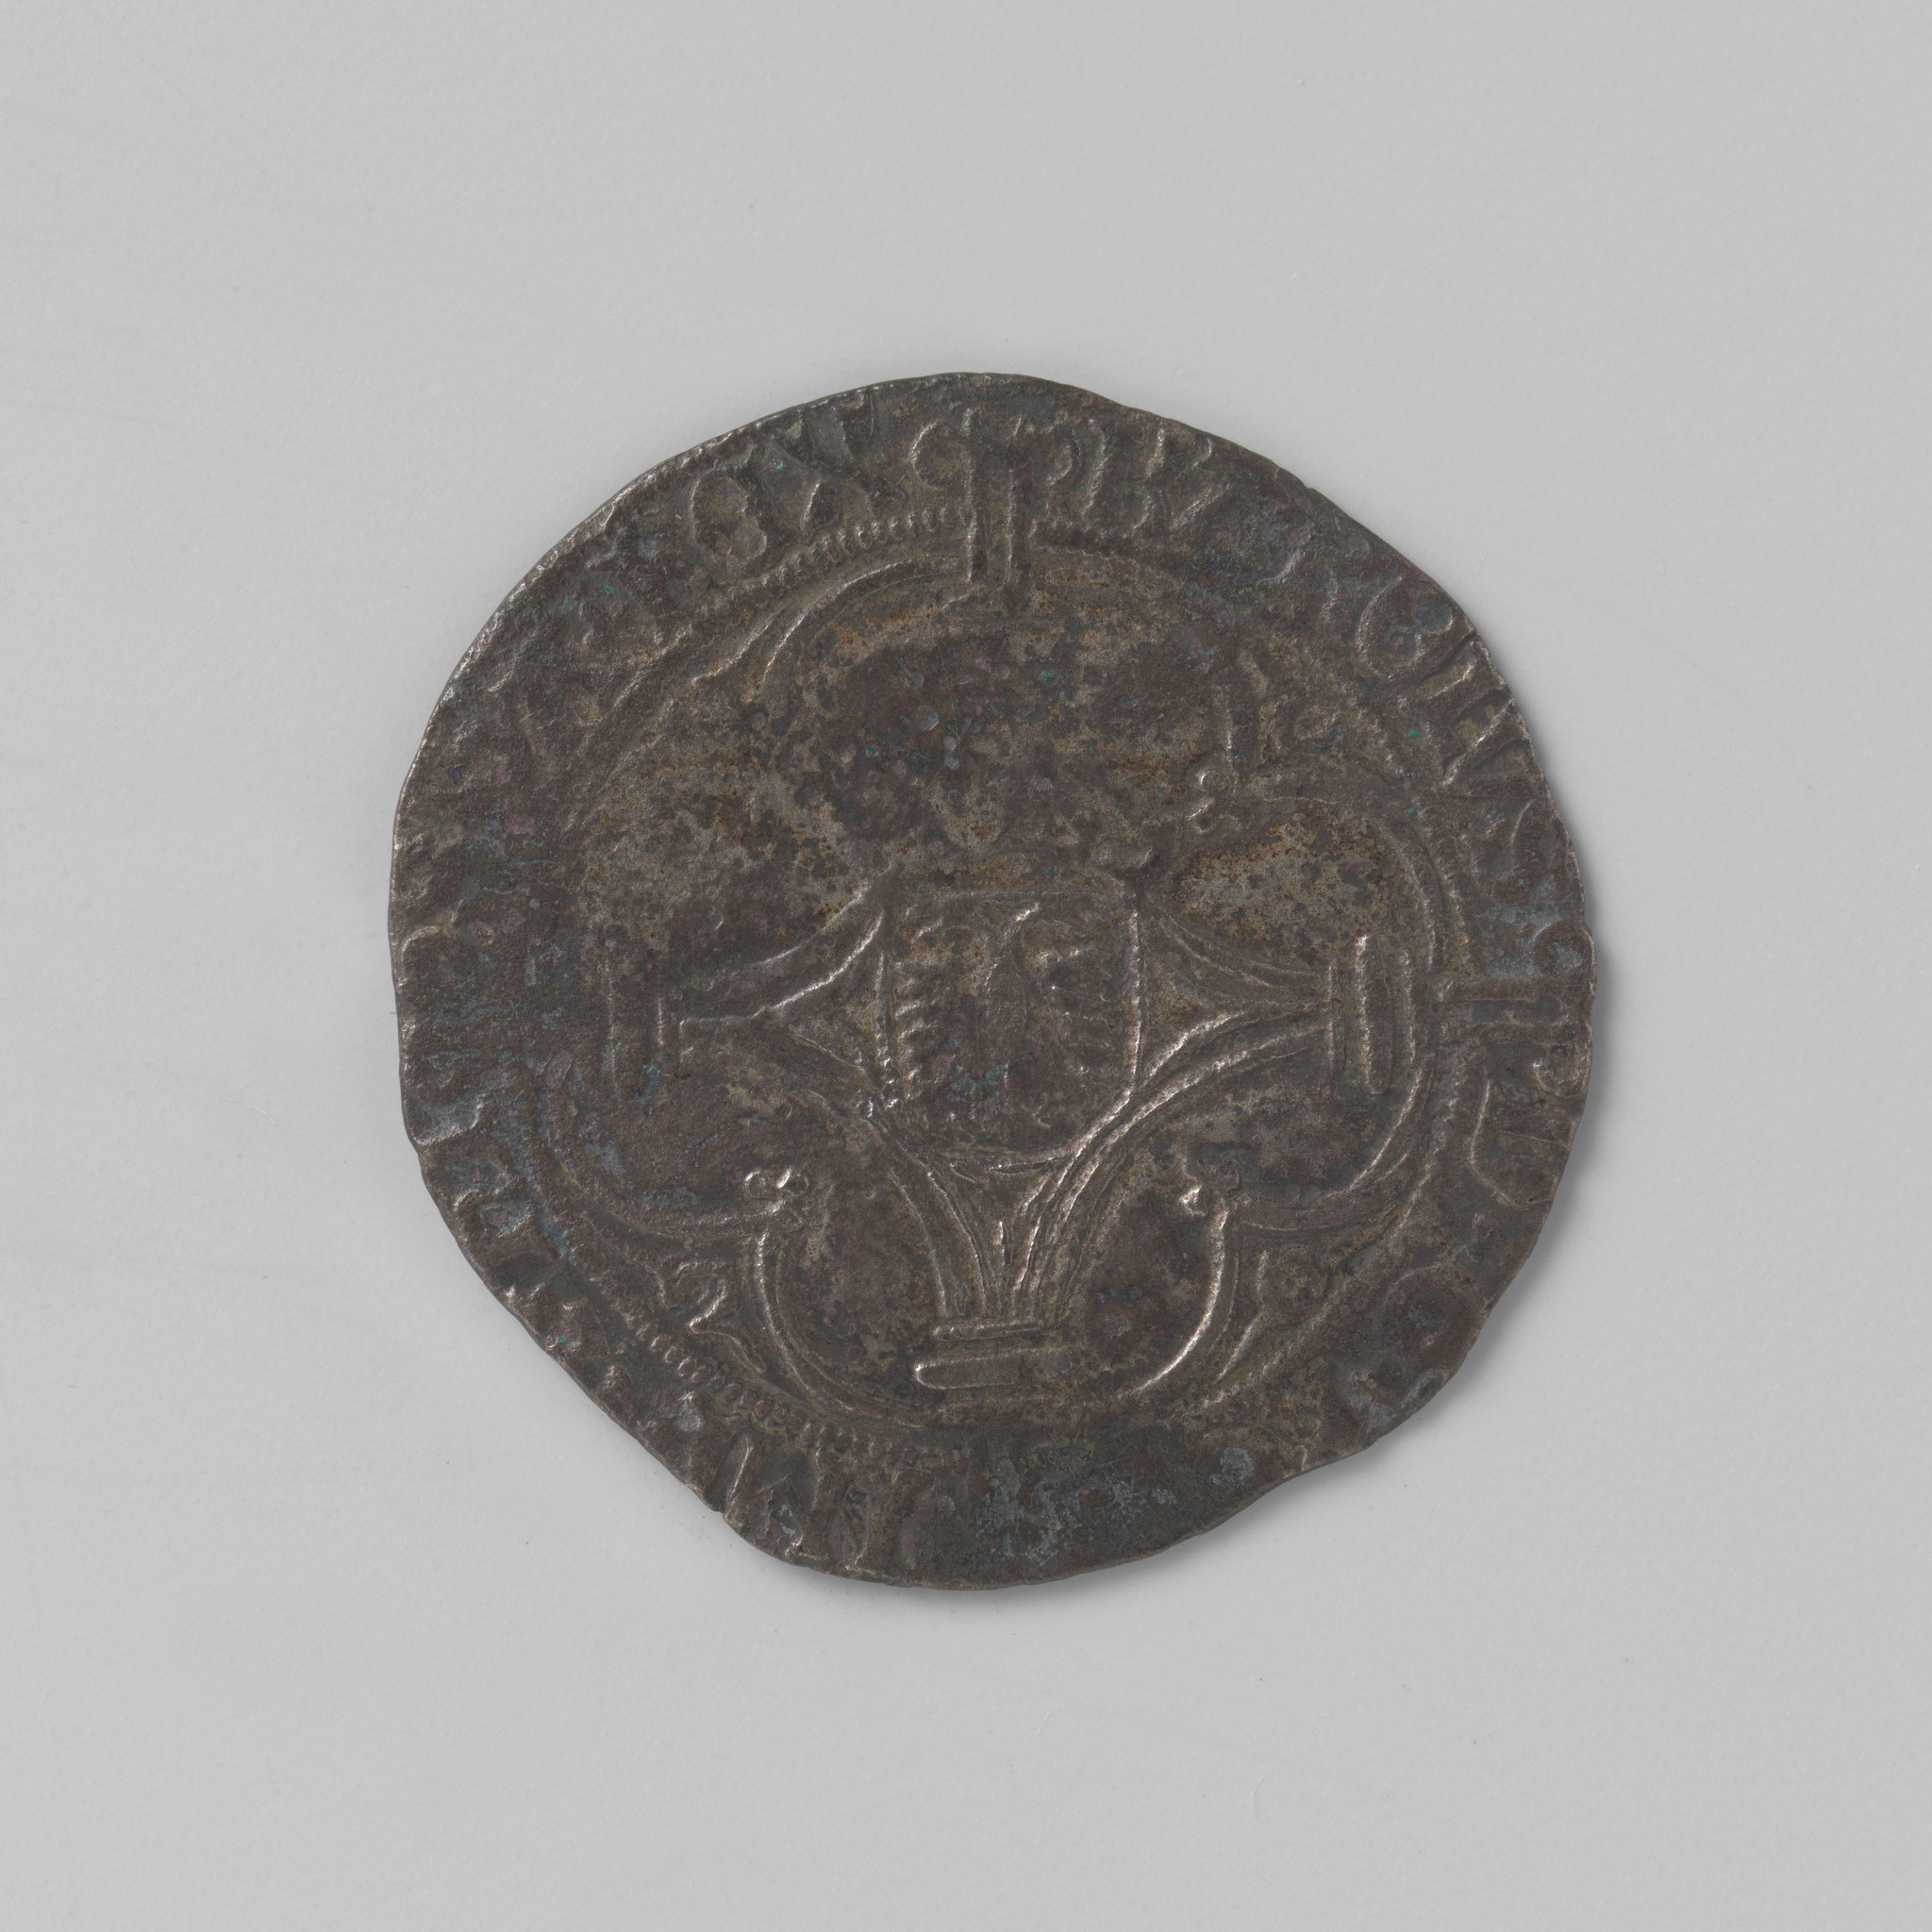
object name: coin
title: Hollandse stuiver van Karel V, 1506-1555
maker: charles v (holy roman emperor and king of spain)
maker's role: keizer, koning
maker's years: 1500-1558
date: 1521-1529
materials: silver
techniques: striking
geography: dordrecht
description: Zilveren munt. Voorzijde: op een vierpas lang versierd kruis, in hart gekroond wapenschild van het Heilige Roomse Rijk. Keerzijde: tussen twee gekruiste knoestige stokken gekroond wapenschild van Oostenrijk-Bourgondië.